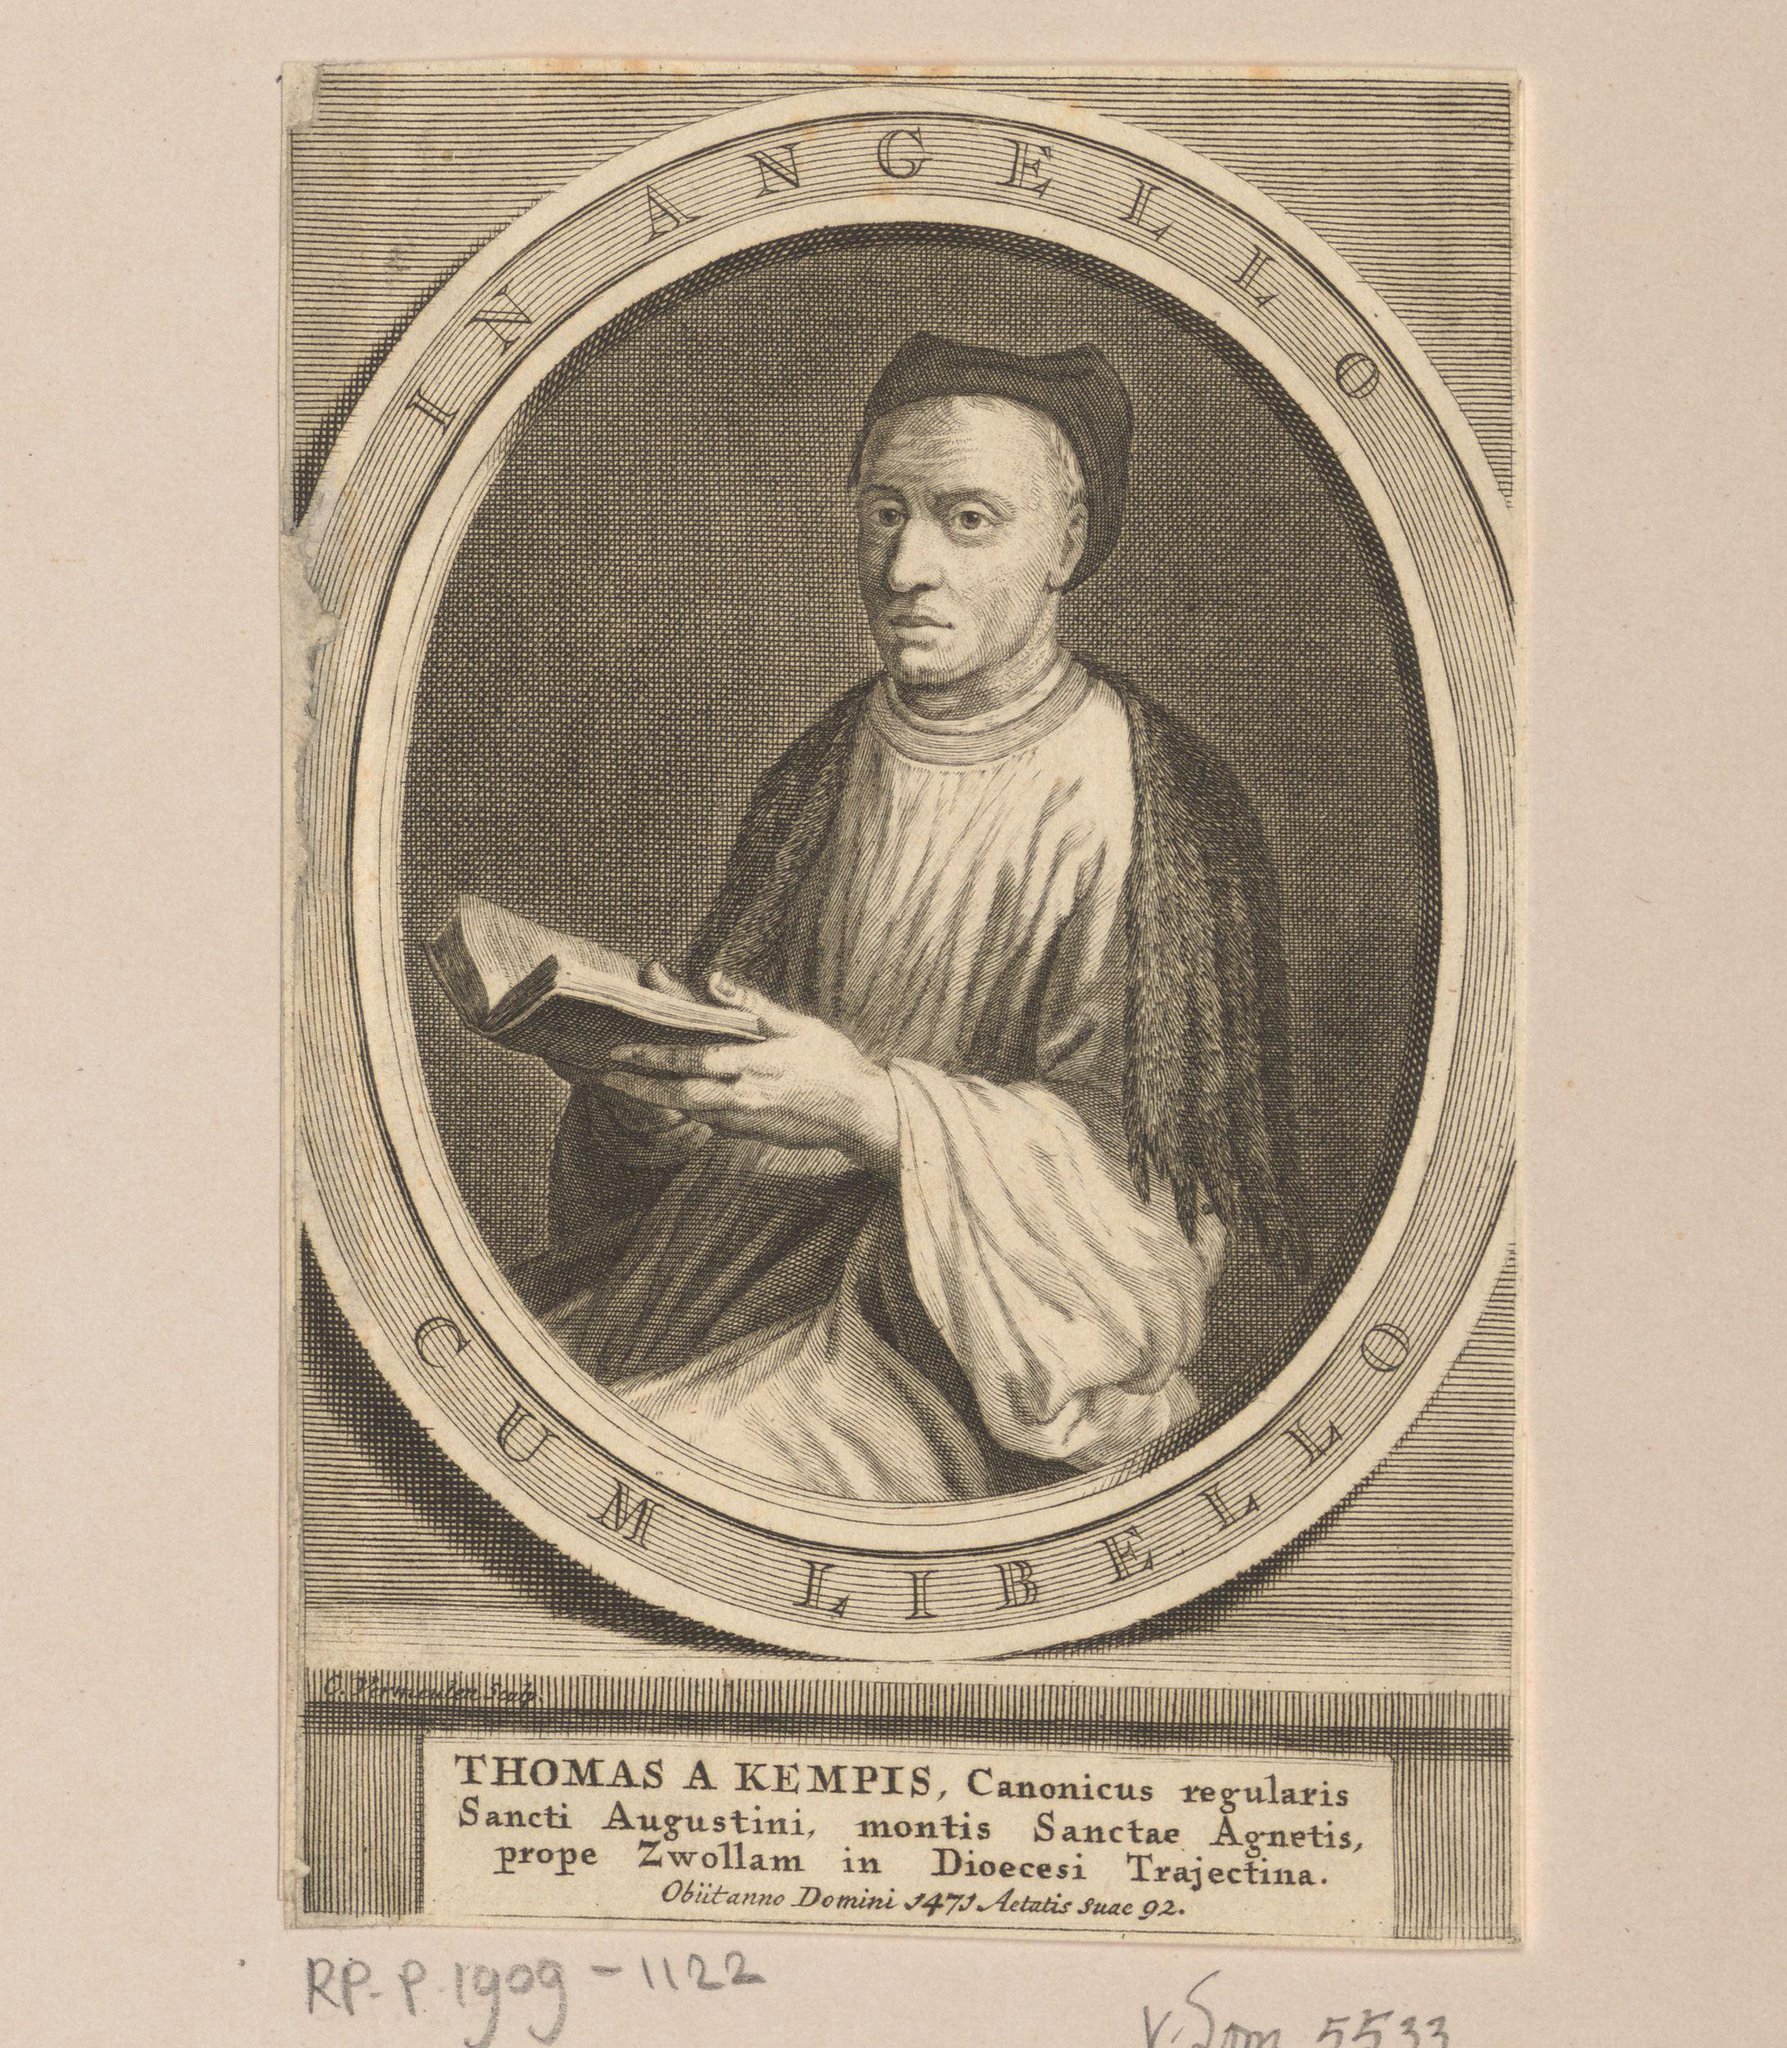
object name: print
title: Portret van Thomas à Kempis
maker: cornelis martinus vermeulen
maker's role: print maker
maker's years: 1644-1709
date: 1654-1709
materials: paper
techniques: engraving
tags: thomas à kempis, historical persons, monk(s), friar(s), book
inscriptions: collector's mark: Lugt 2228